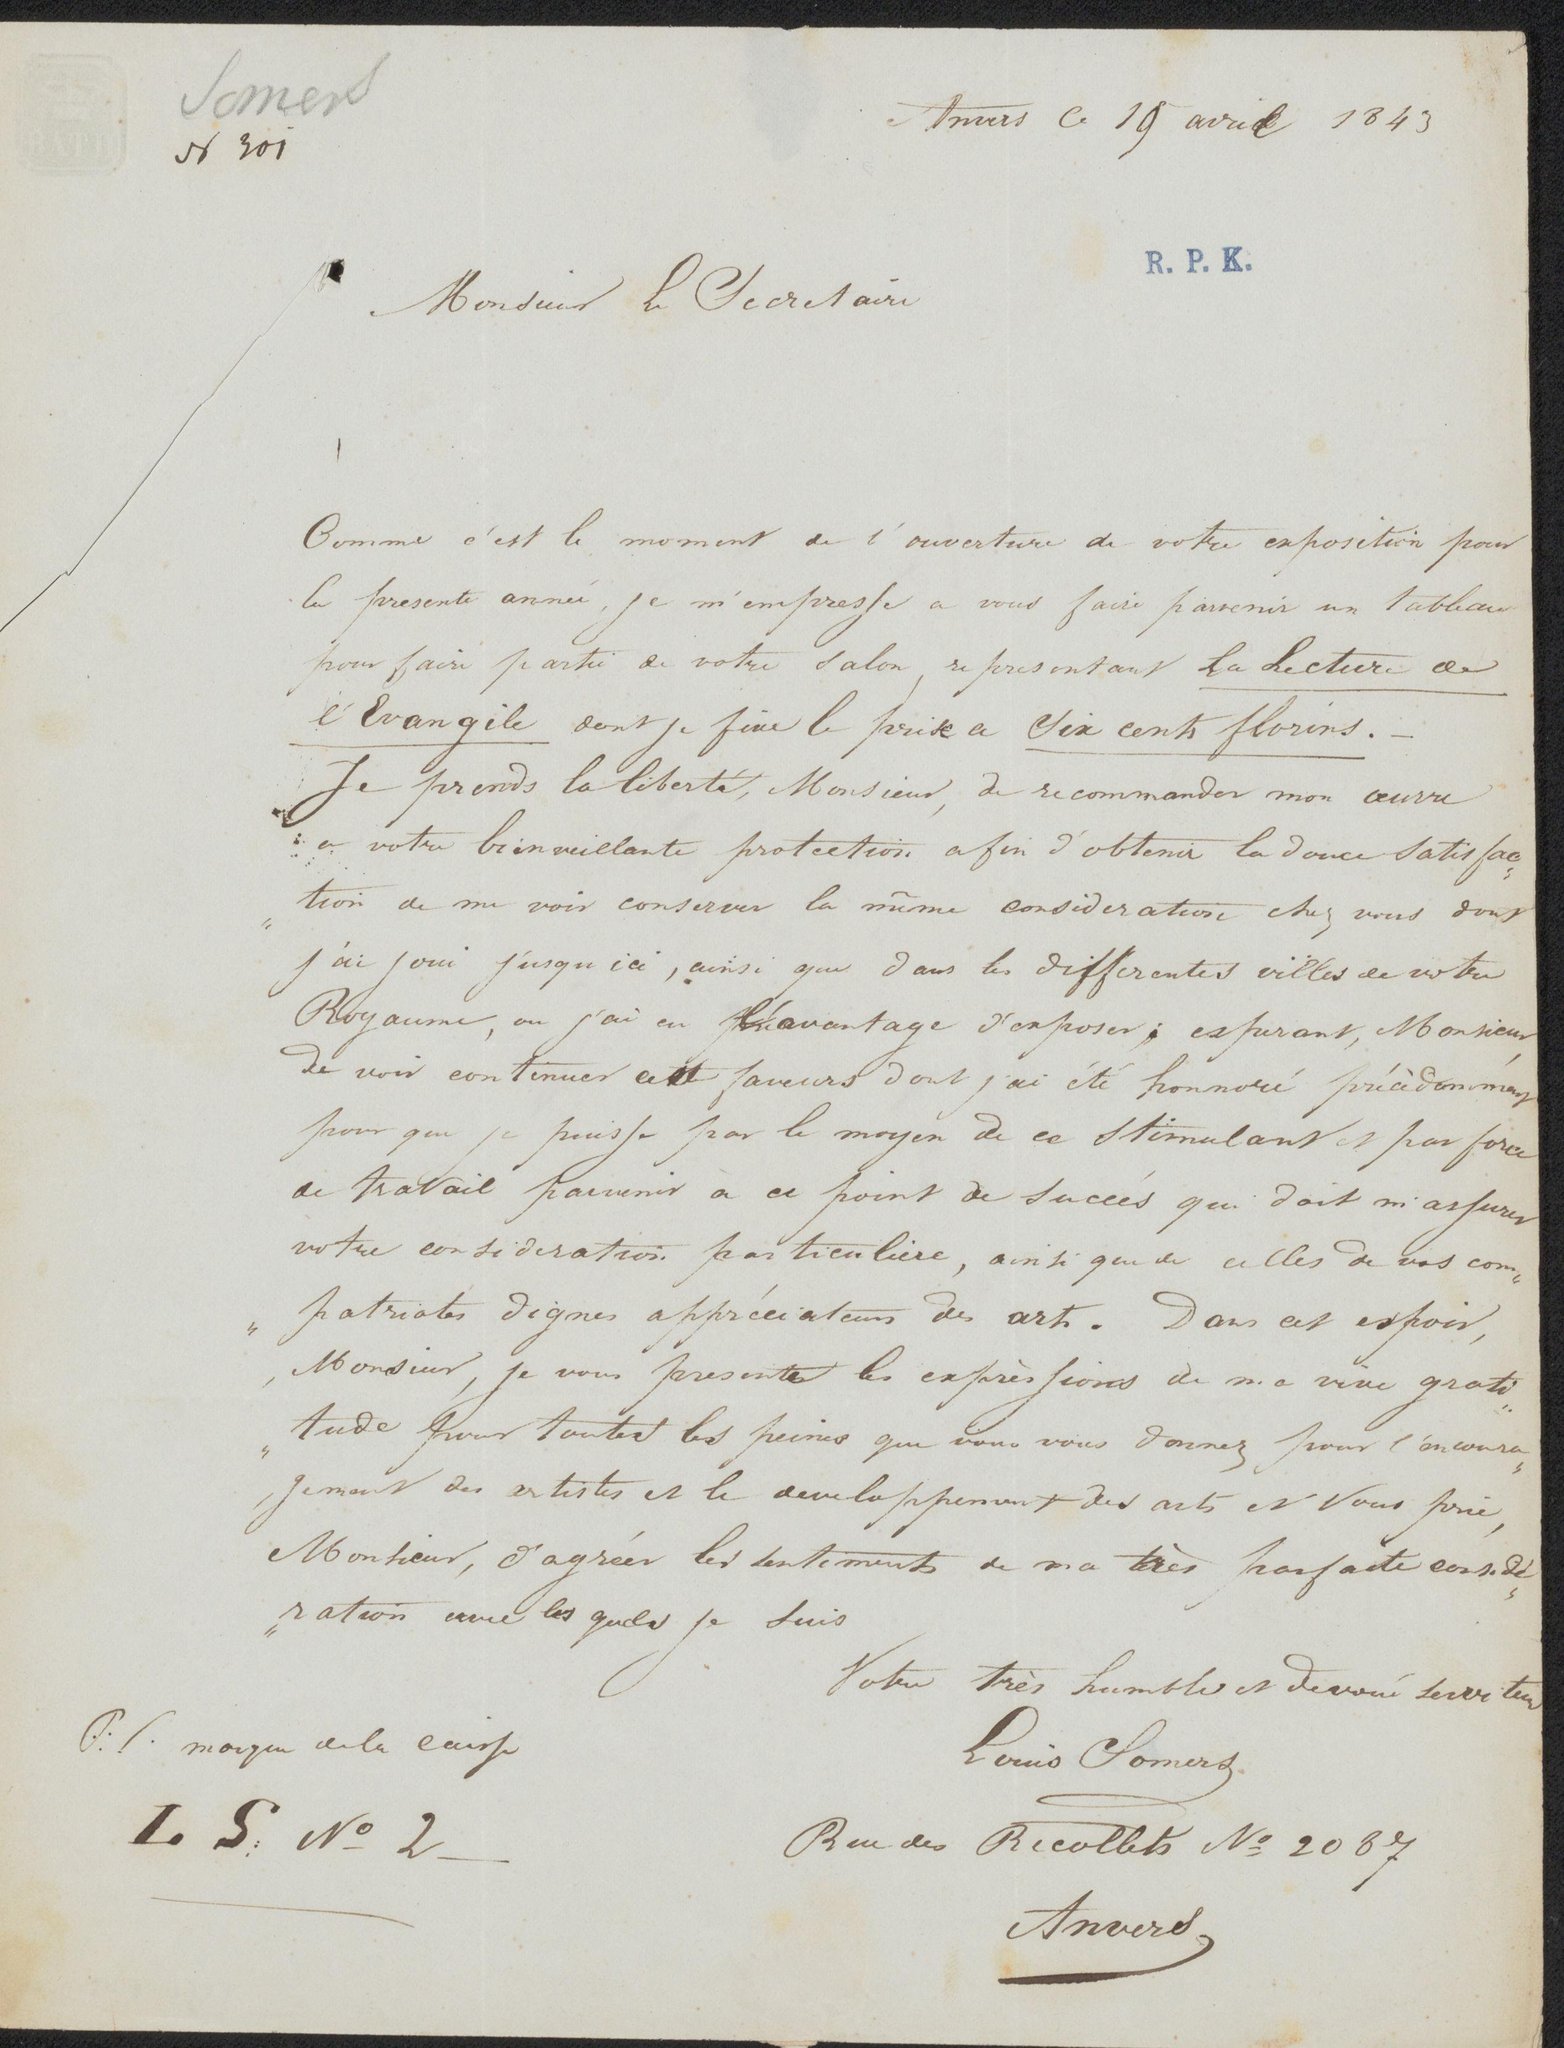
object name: letter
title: Brief aan G.M.C. Hooft, secretaris van de Commissie van de Tentoonstelling van Levende Meesters in Den Haag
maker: louis jean somers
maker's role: draughtsman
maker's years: 1813-1880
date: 1843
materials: ink, paper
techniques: pen, writing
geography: antwerp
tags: painting (including book-illumination, miniature-painting), exhibition ~ art, money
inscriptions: collector's mark: ‘RPK’